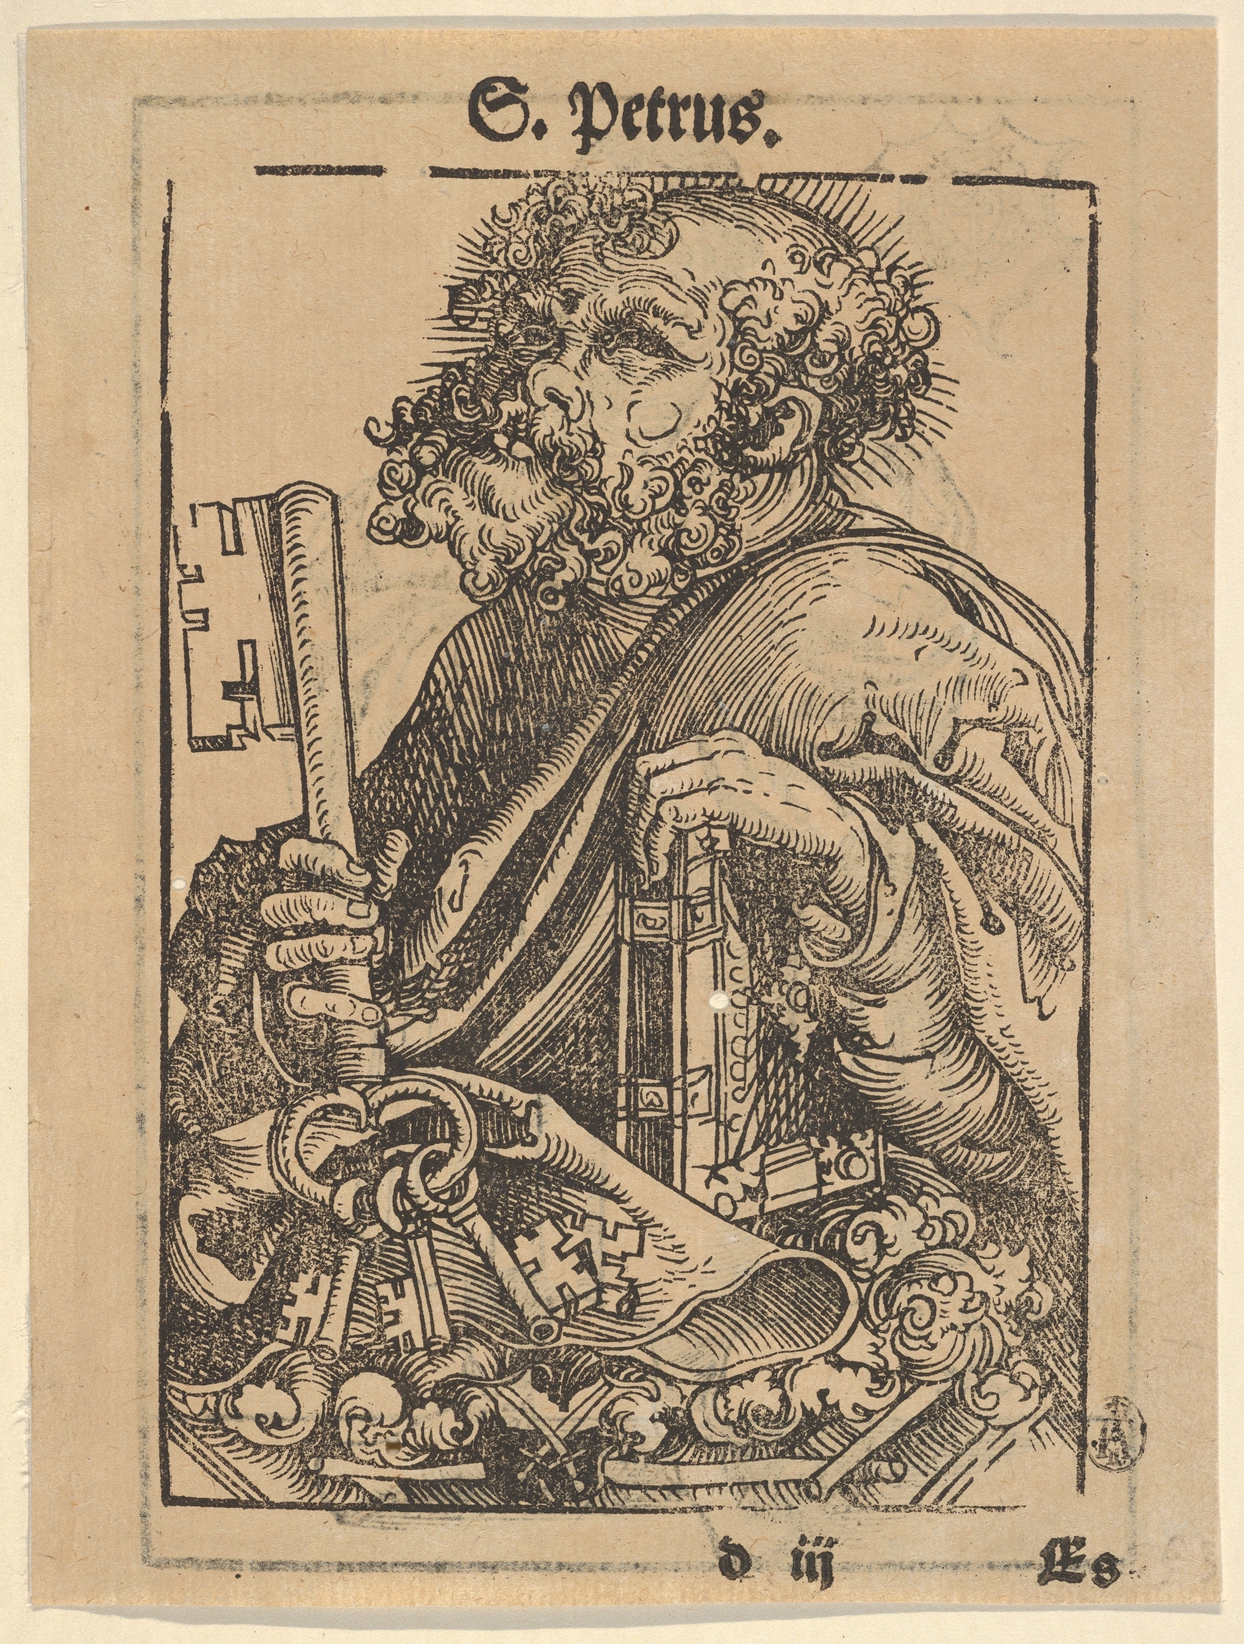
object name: print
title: Bust of Saint Peter, from the "Large Series of Wittenberg Reliquaries"; verso: Martin Luther (1548)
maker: lucas cranach the elder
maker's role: artist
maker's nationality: german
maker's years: 1472-1553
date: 1509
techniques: woodcut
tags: portraits,saint peter